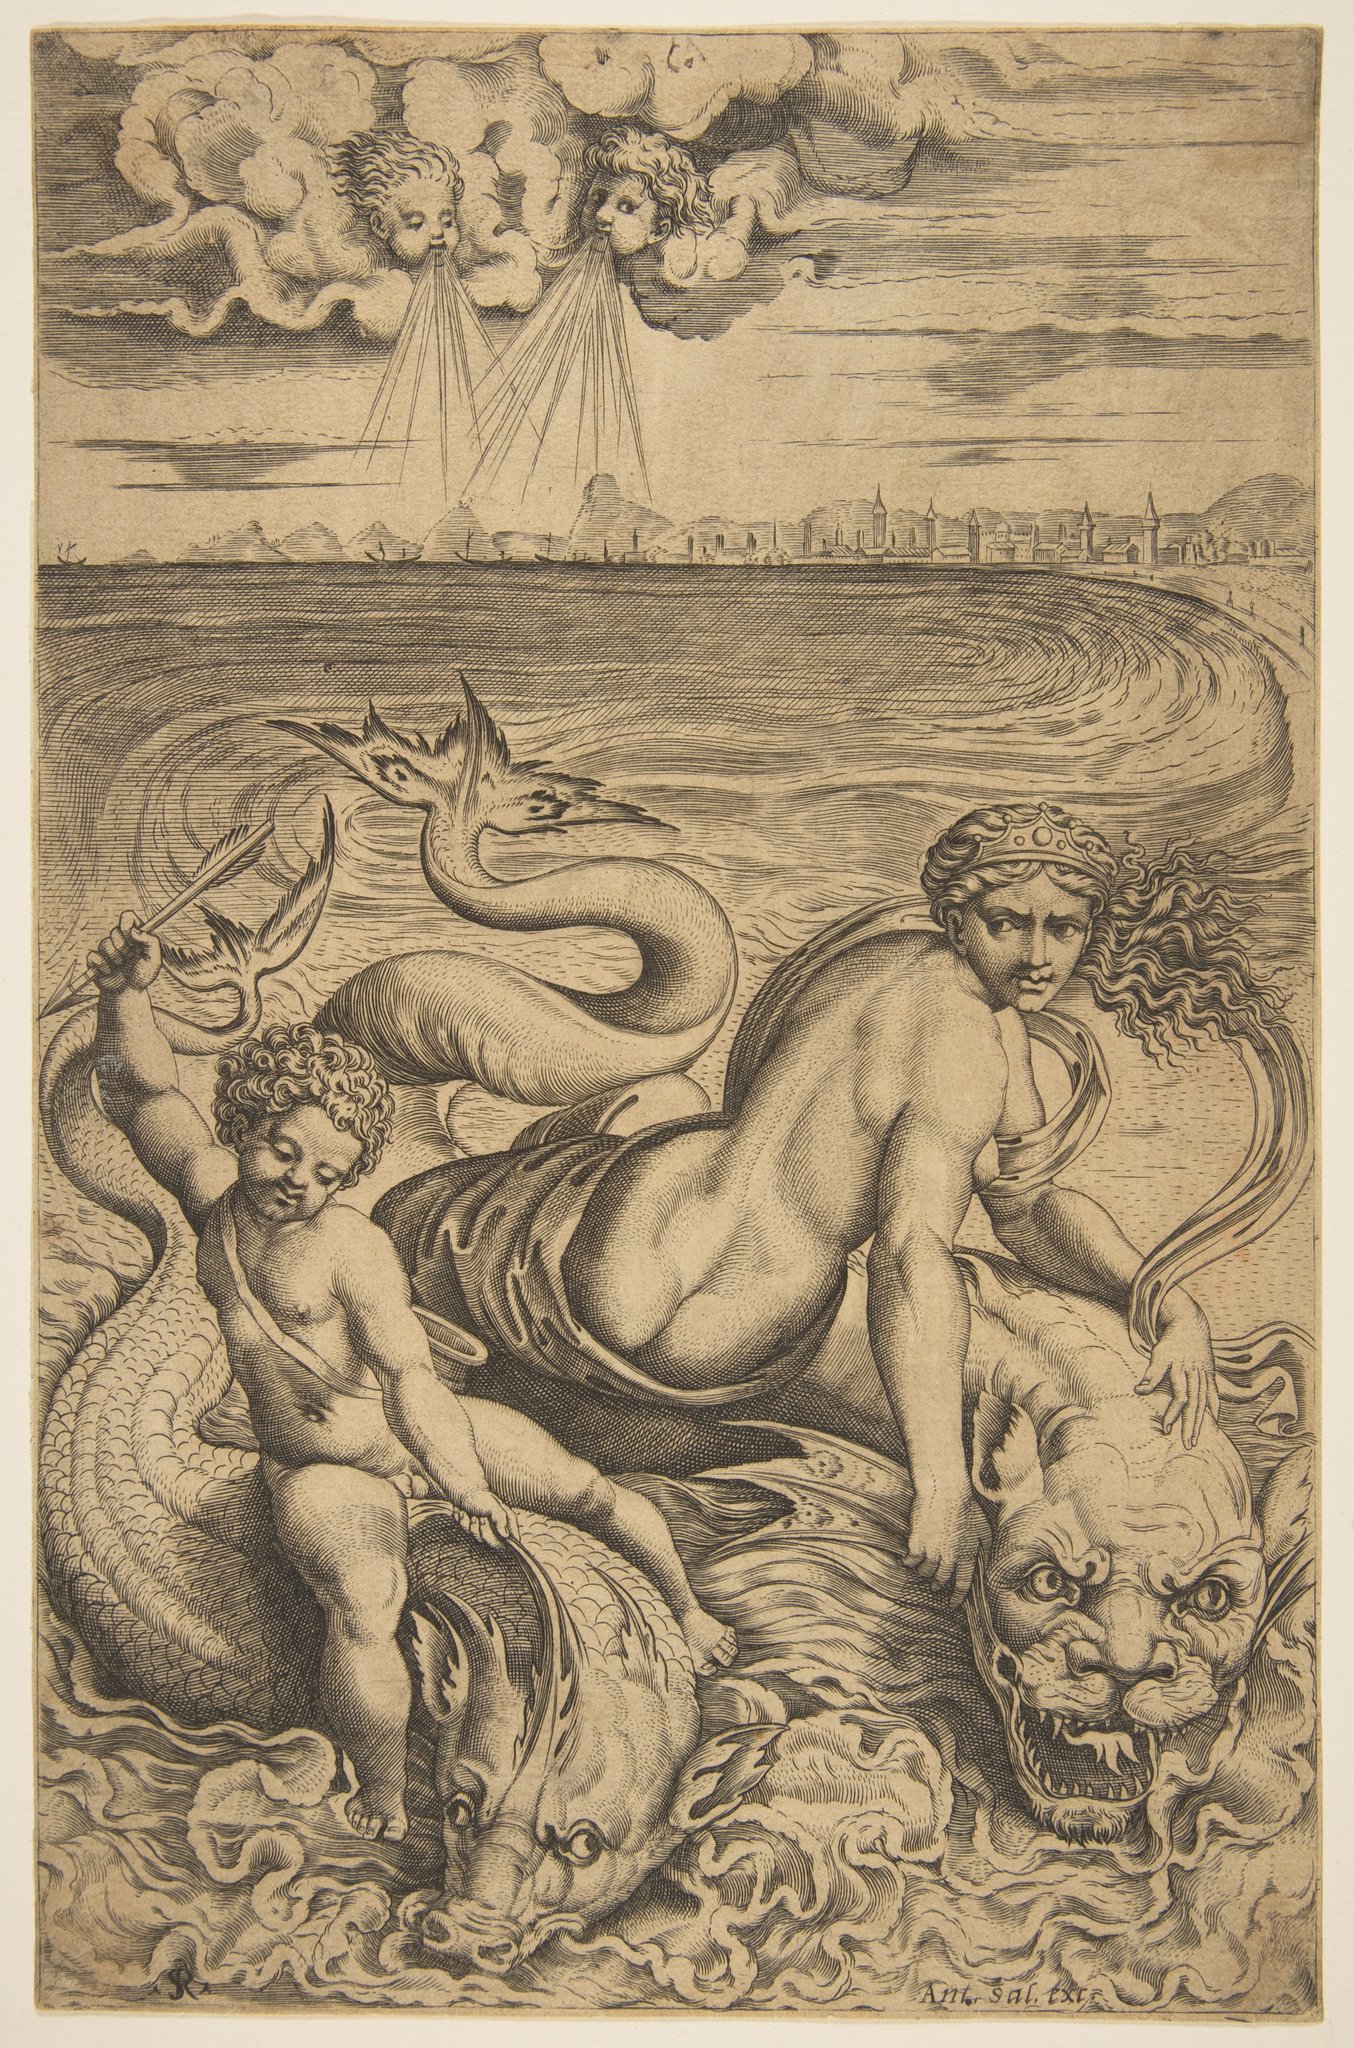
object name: print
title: Venus and Cupid riding two sea monsters, Cupid raises an arrow in his right hand, two heads representing wind in the clouds above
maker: marco dente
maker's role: artist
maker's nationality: italian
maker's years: 1515-1527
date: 1515-1527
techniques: engraving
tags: cupid,monsters,venus